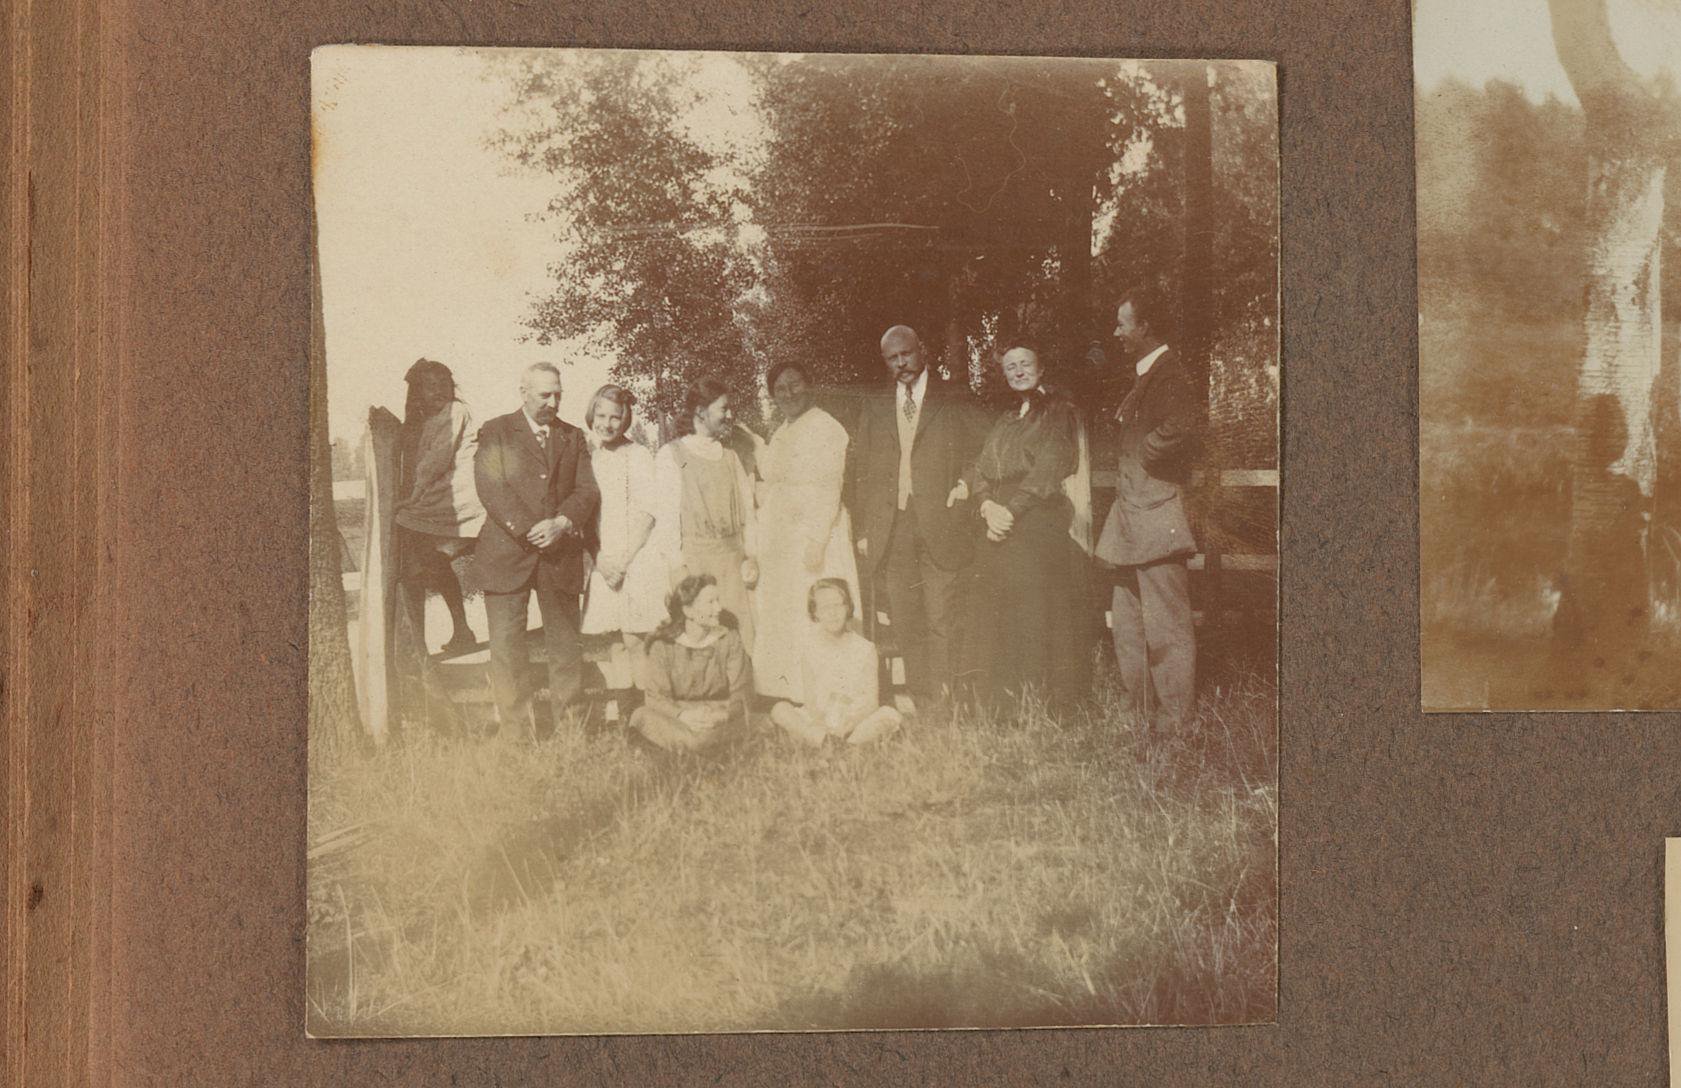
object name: photograph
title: Groepsportret in veld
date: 1908-1915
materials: photographic support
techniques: photography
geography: netherlands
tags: netherlands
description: Foto op bruin albumblad 48 van familiealbum van Alphons Diepenbrock.